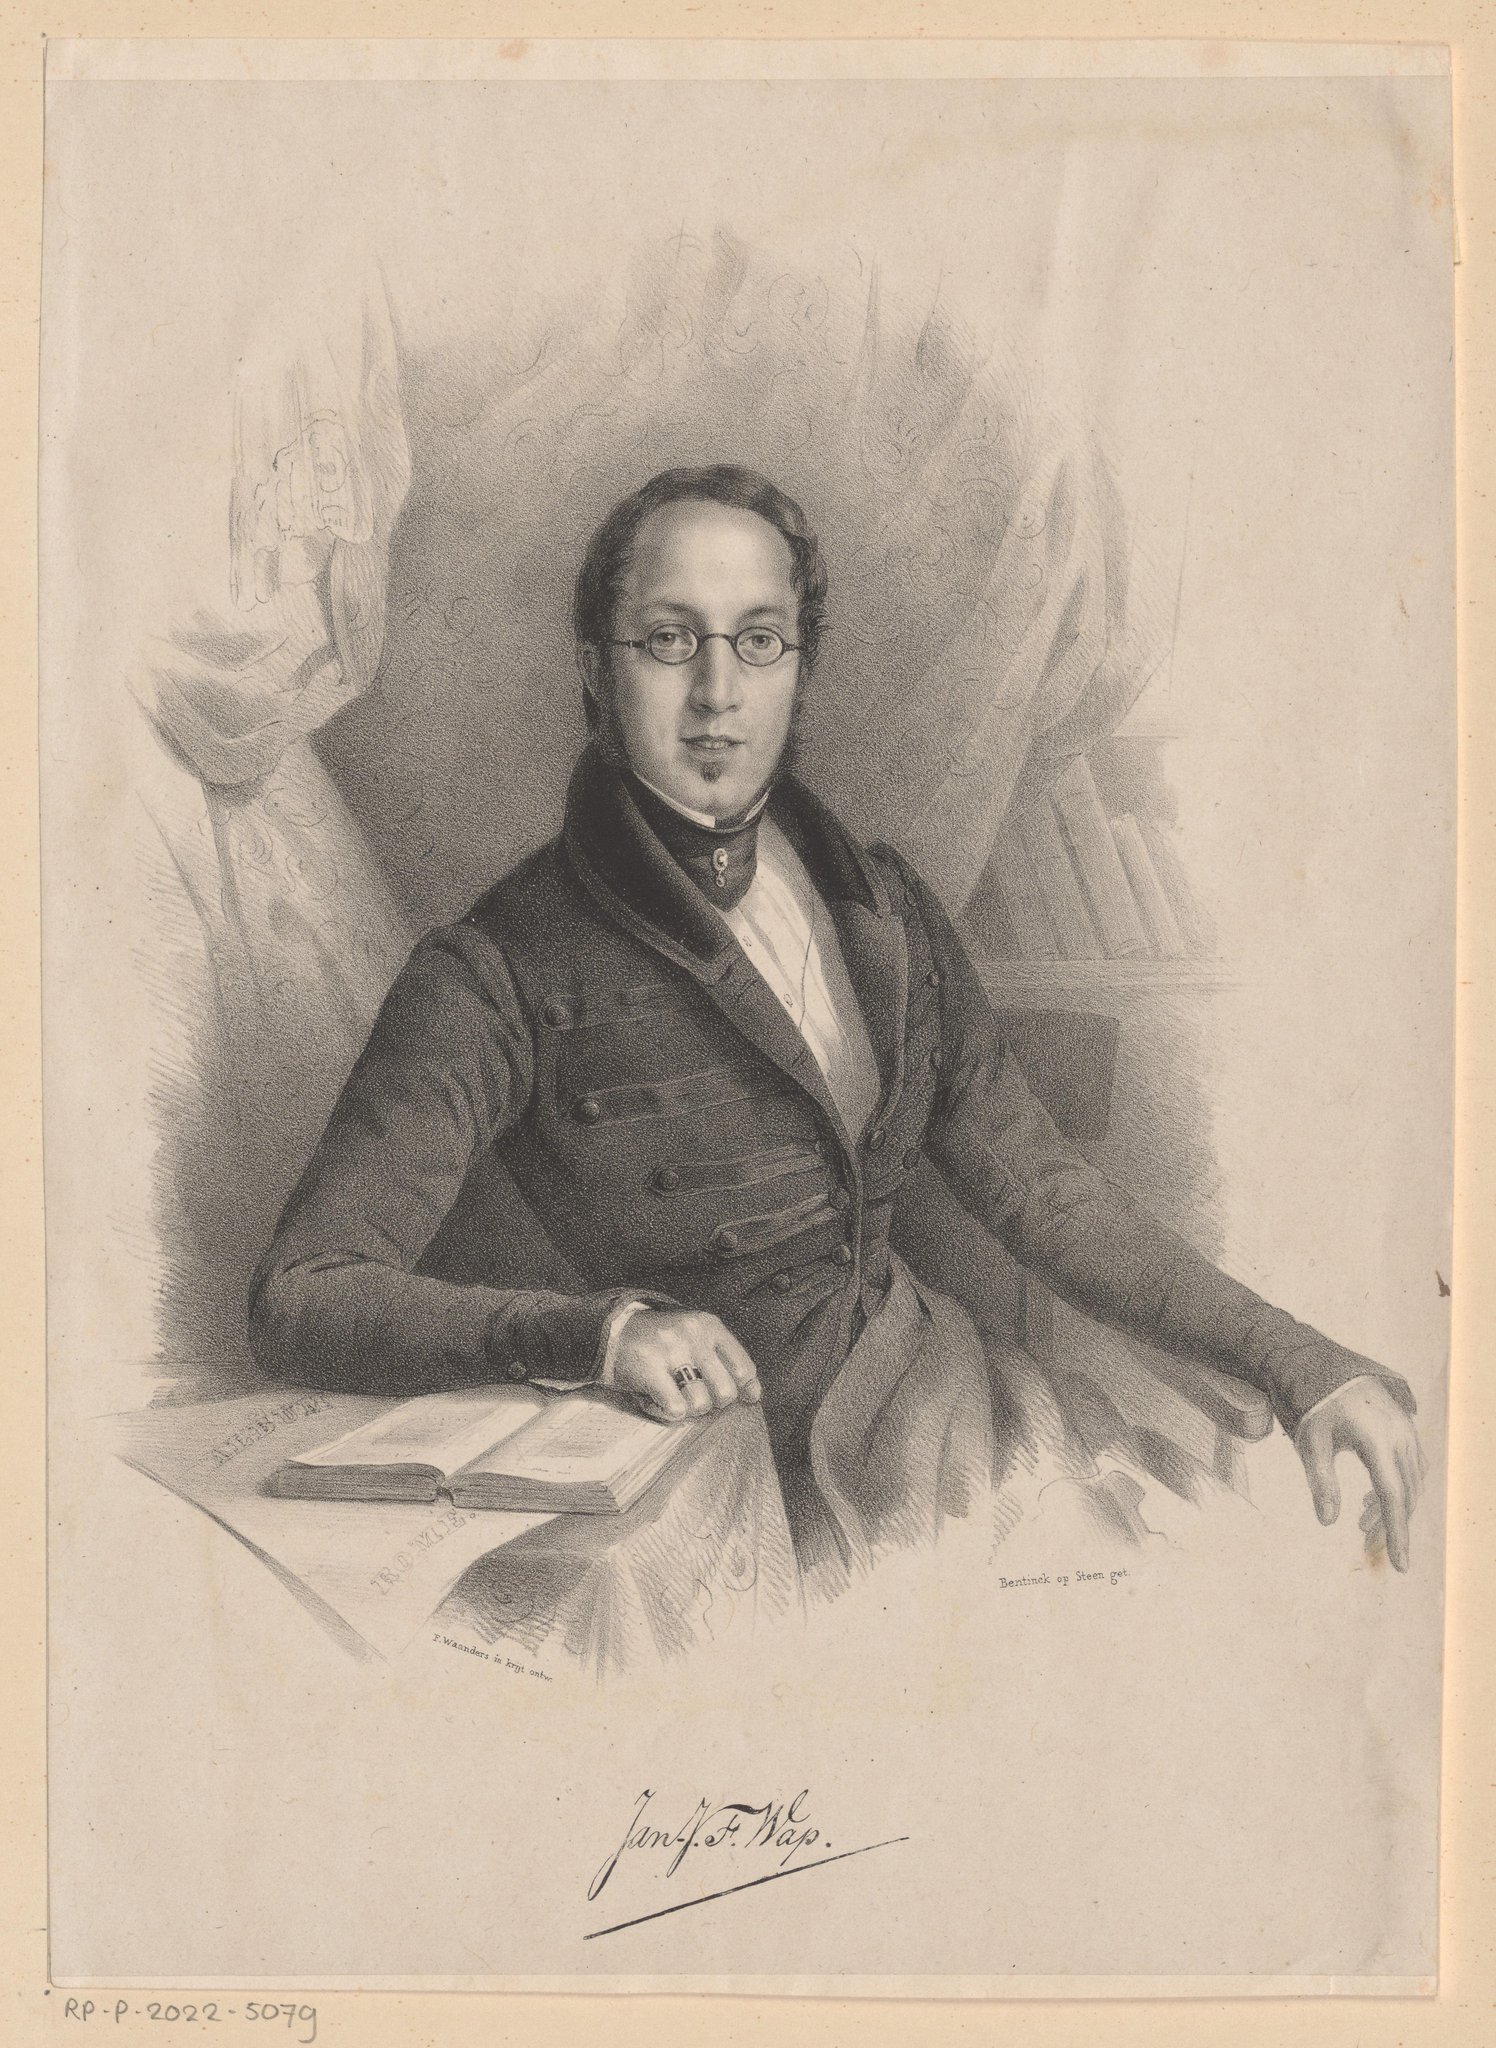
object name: print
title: Portret van Johannes Jacobus Franciscus Wap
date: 1837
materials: paper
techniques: lithograph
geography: dordrecht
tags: johannes jacobus franciscus wap, bookshelves, historical persons, book - mm - book open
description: Handtekening onder portret in facsimile.